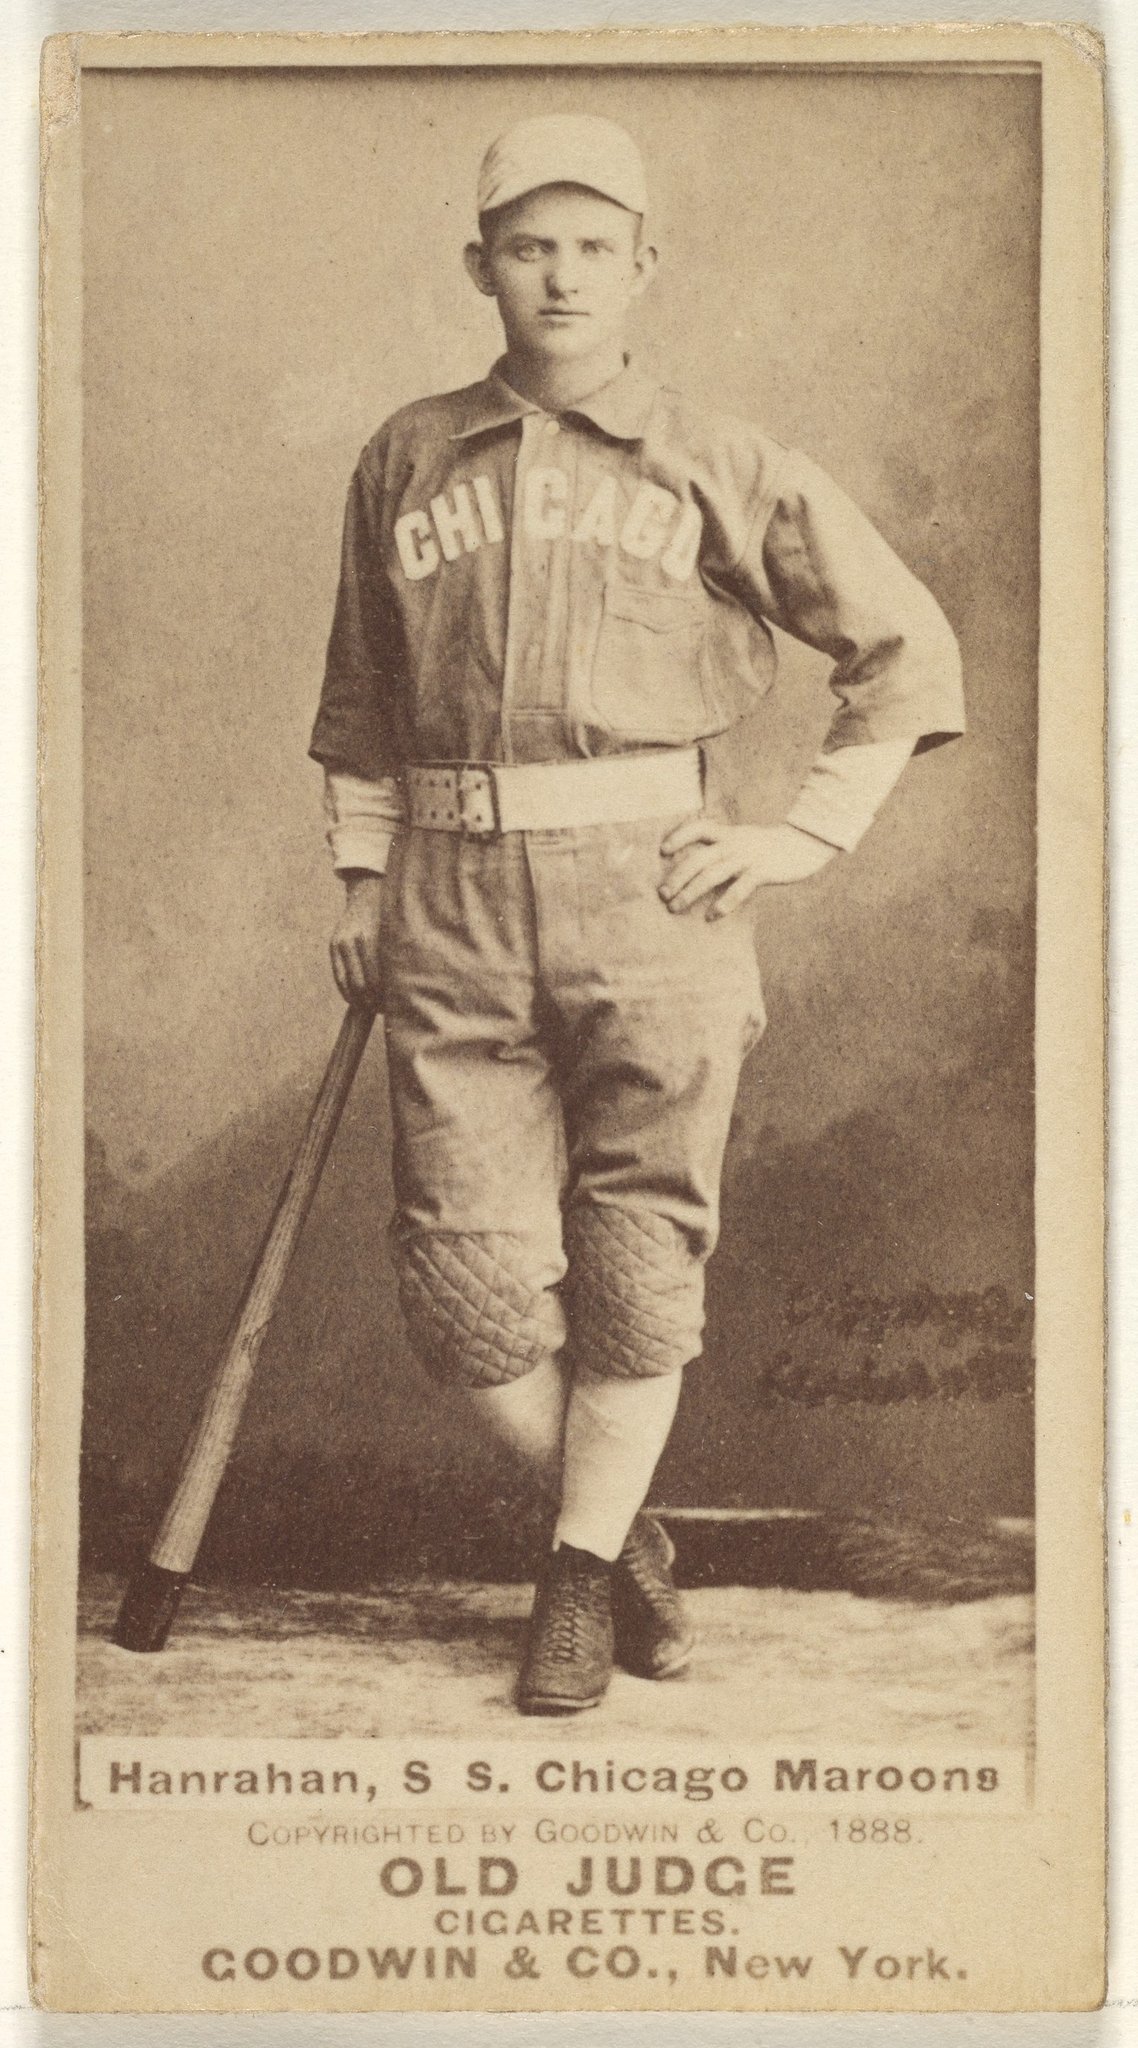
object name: baseball card, photograph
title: Hanrahan, Shortstop, Chicago, from the Old Judge series (N172) for Old Judge Cigarettes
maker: goodwin & company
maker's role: publisher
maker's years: 1850-1950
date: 1887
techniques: albumen silver print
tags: men,portraits,baseball,athletes